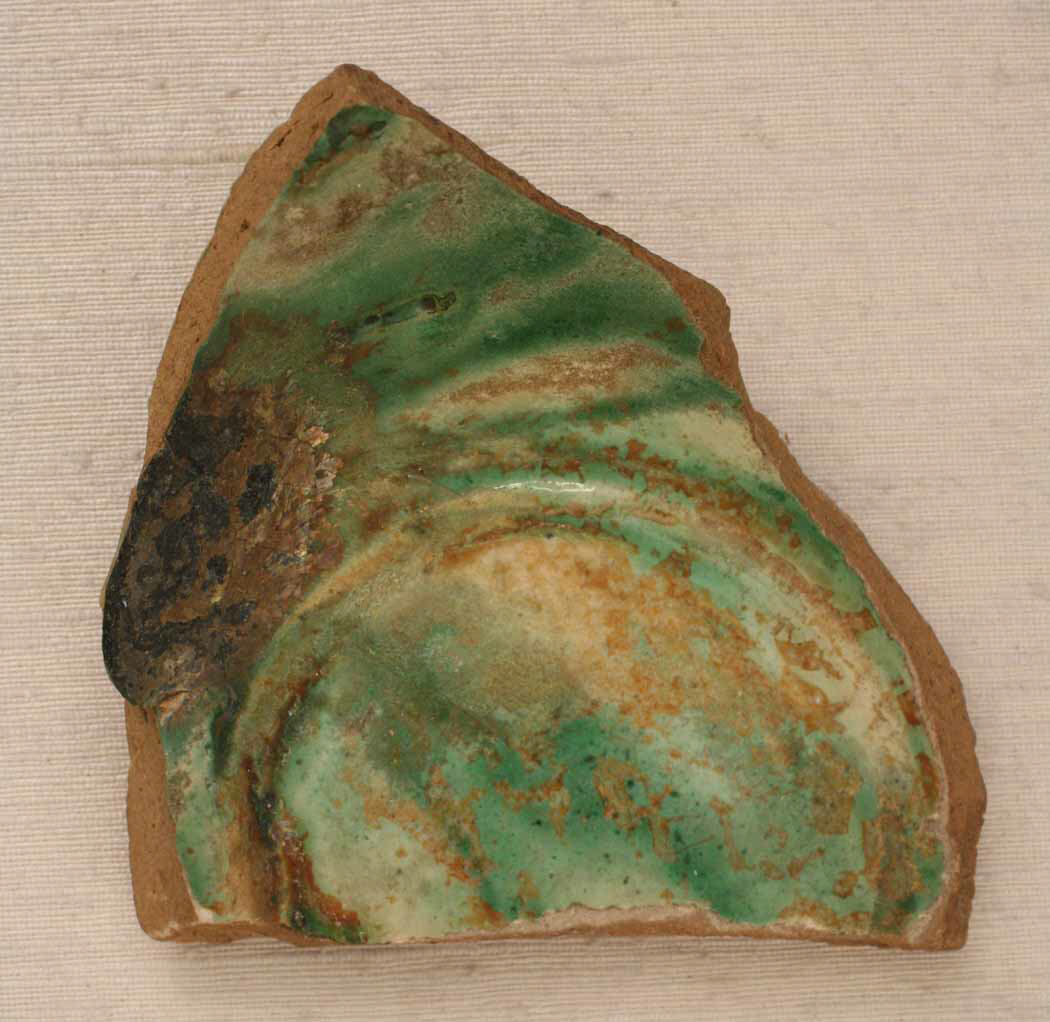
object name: fragment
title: Ceramic Fragment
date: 701-900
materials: earthenware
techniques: glazing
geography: iraq